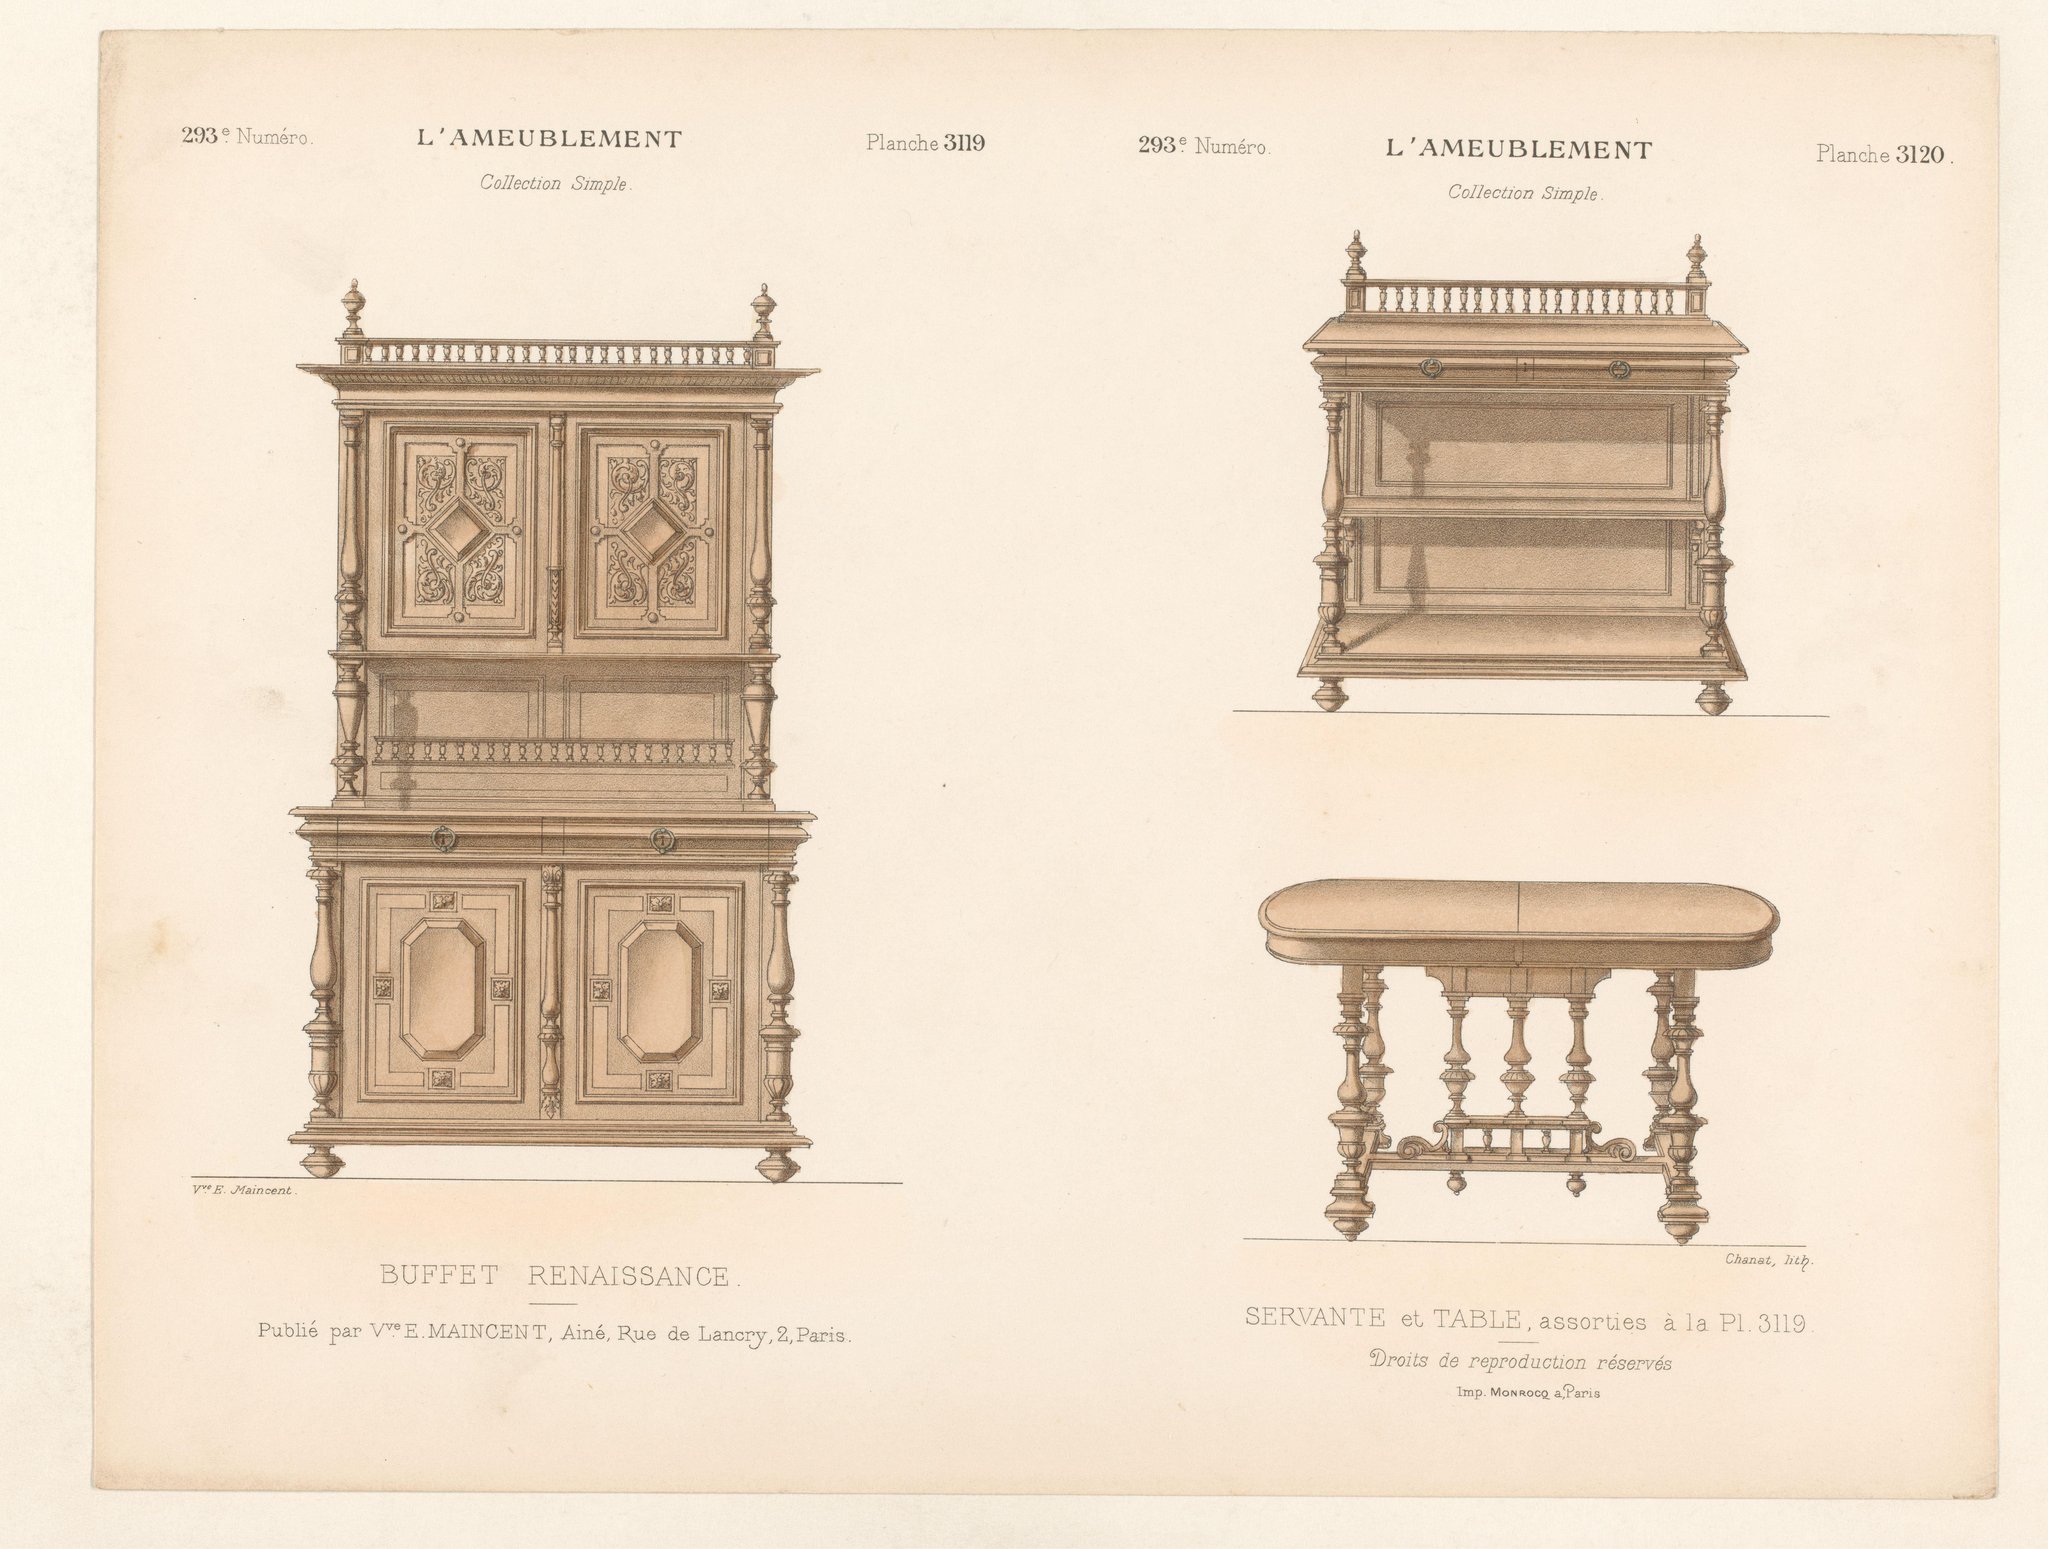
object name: print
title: Buffet renaissance / Servante et table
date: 1895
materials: paper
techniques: hand coloring, lithograph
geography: paris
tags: furniture for storage, table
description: Een renaissance buffetkast, open kast en tafel. Prent uit 293e Livraison.